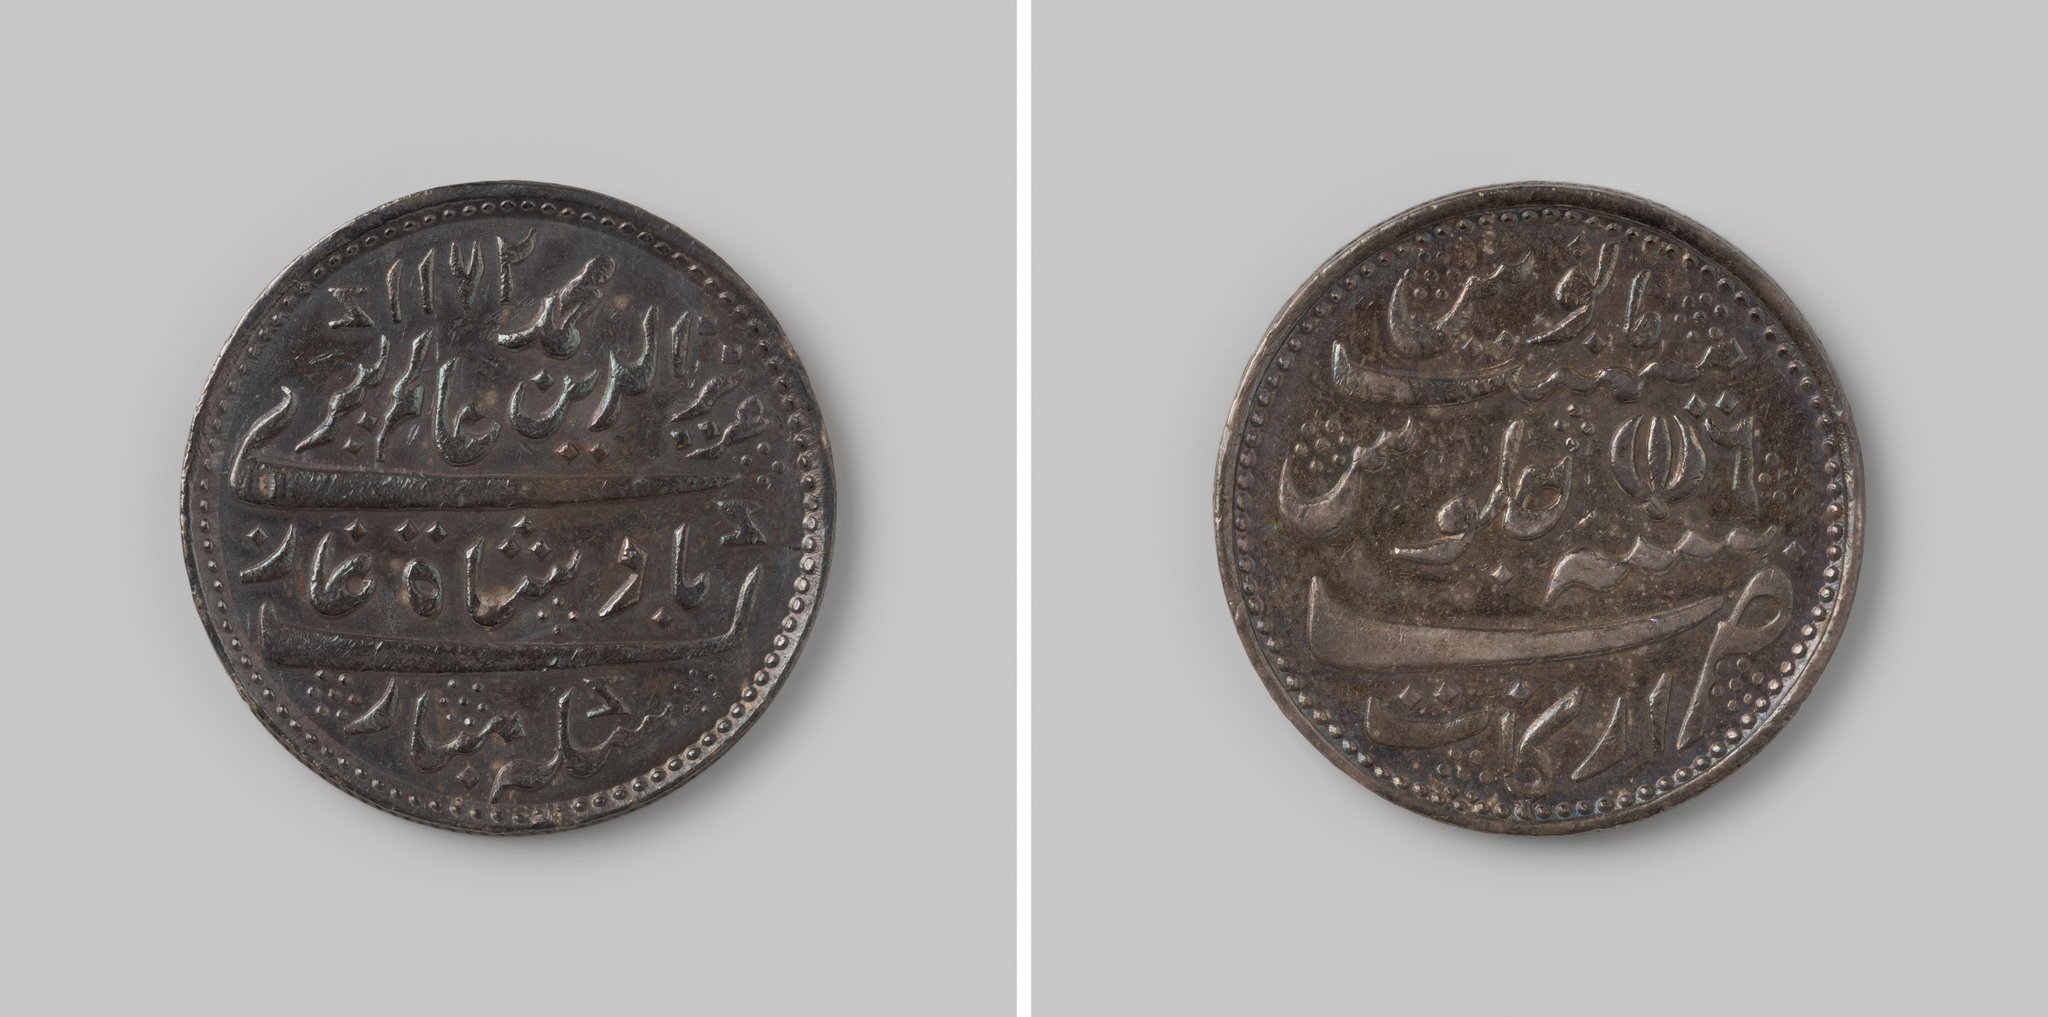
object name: coin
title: Arkot-roepie voor Madras in India van de Engelse Oostindische Compagnie (EIC) op naam van sjah Alamgir II,1172 [=1759]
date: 1817-1835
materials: silver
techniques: striking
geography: chennai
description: Zilveren munt. Voorzijde: in Arabische lettertekens in drie regels opschrift met bovenaan aanduiding jaartal: 1172. Keerzijde: in Arabische lettertekens in drie regels opschrift. Boven tweede regel aanduiding regeringsjaaar: 6 met links daarvan lotusbloem [=muntplaats Madras]. Geslagen in de jaren 1817-1835 te Madras. Inwendige kabelrand.